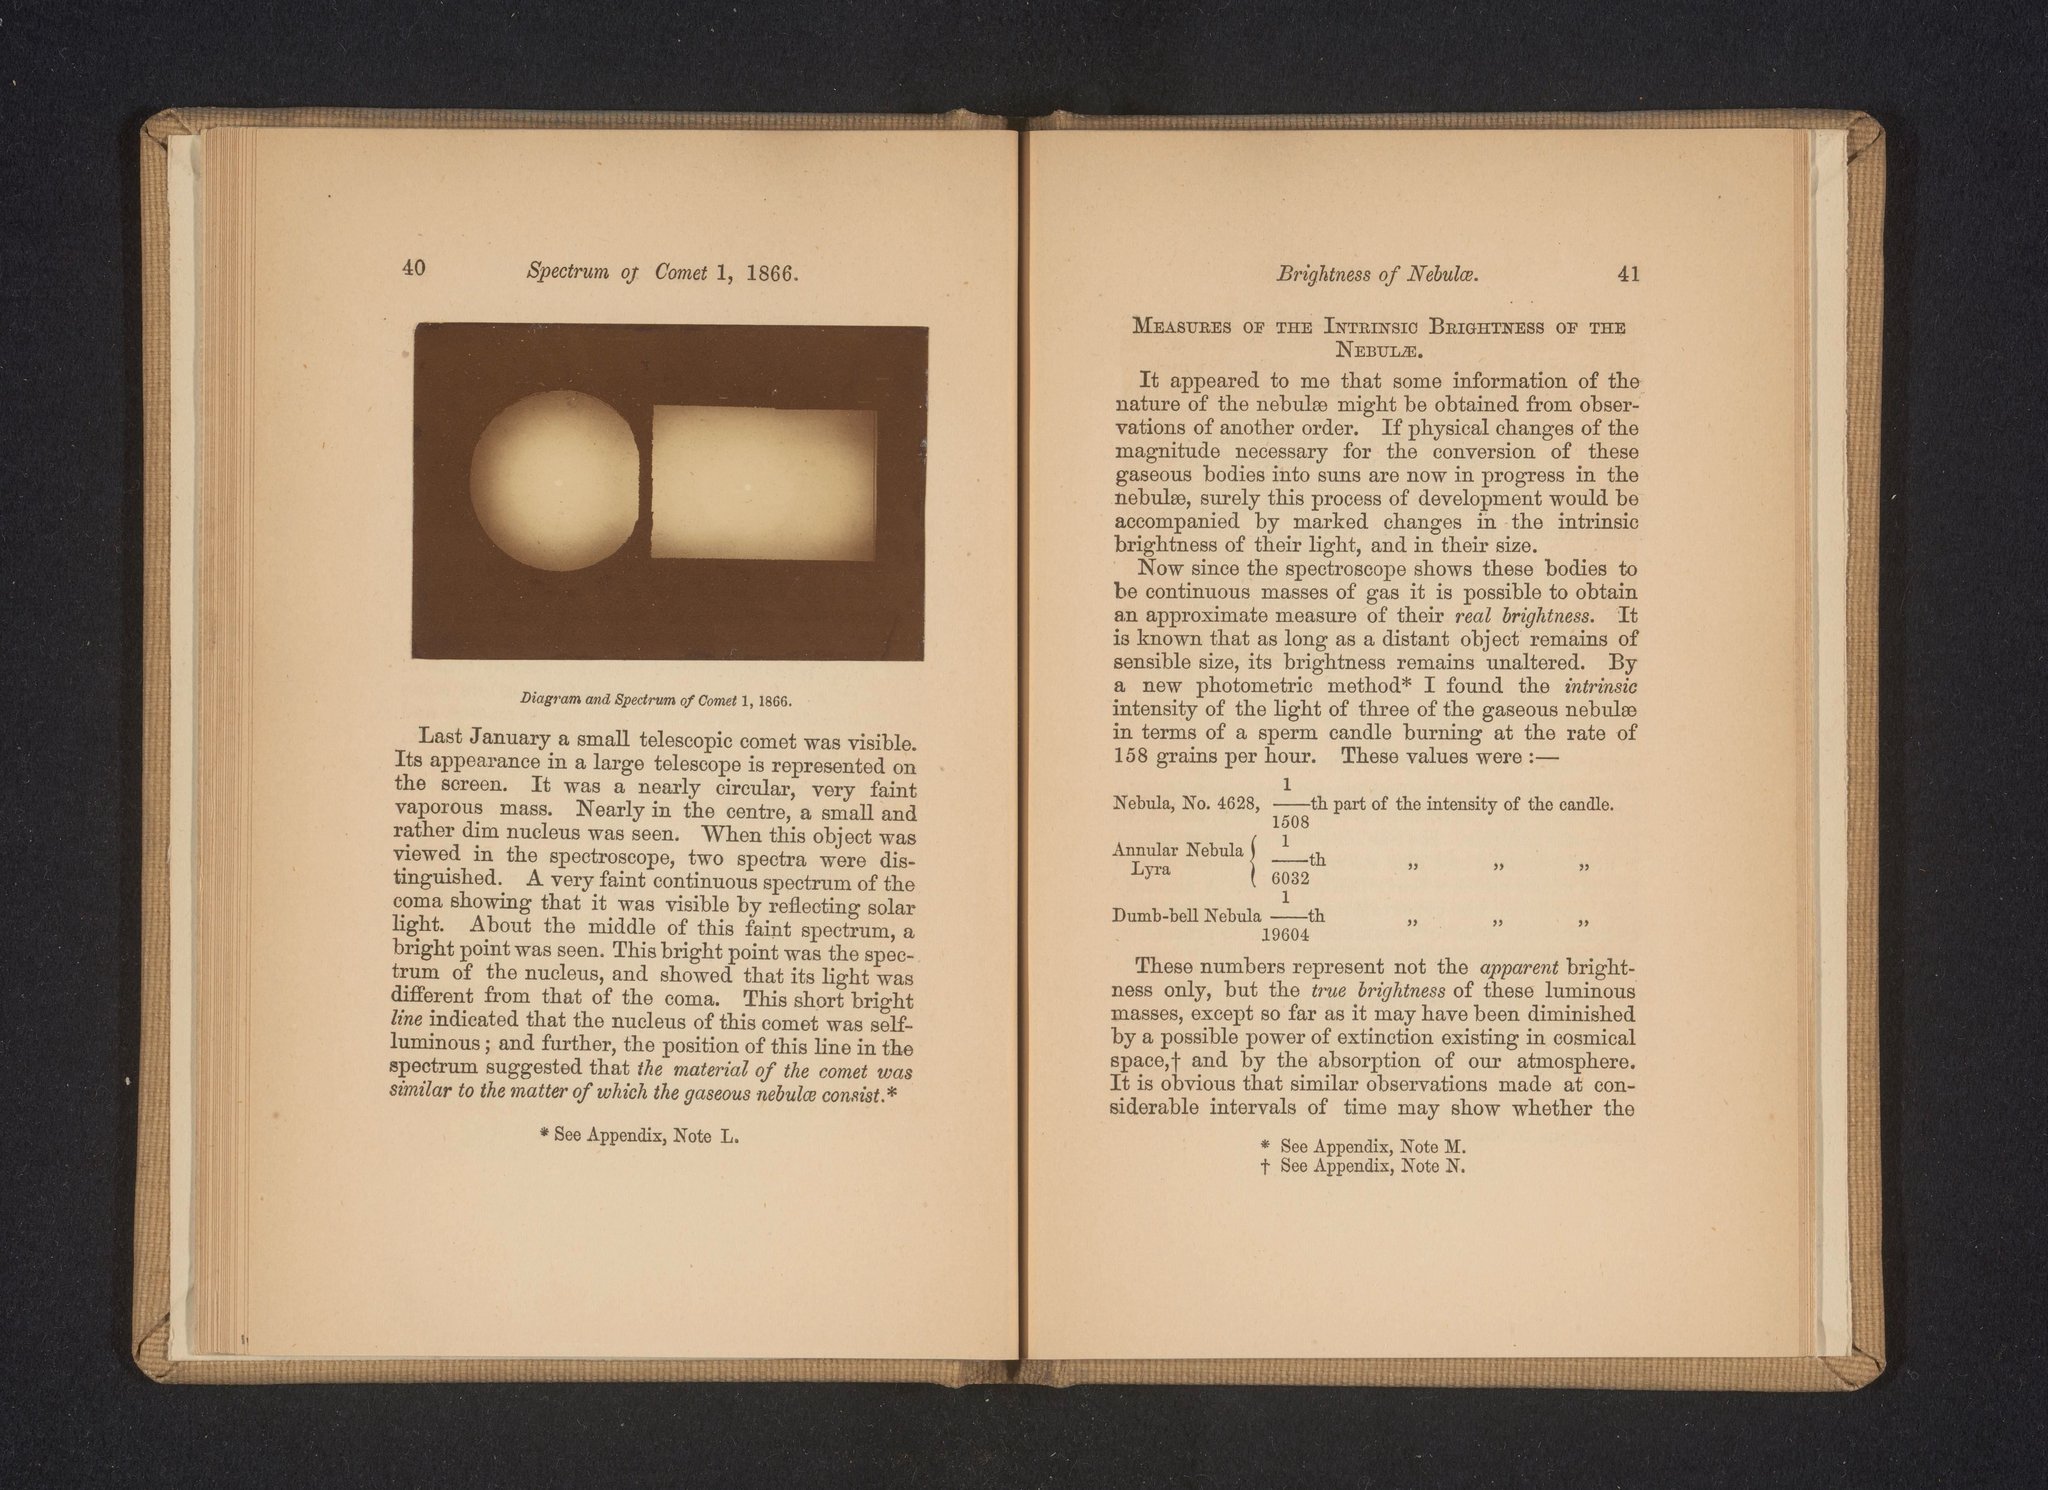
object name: photograph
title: Diagram en kleurenspectrum van een komeet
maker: Anonymous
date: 1866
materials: photographic support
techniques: albumen print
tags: comet